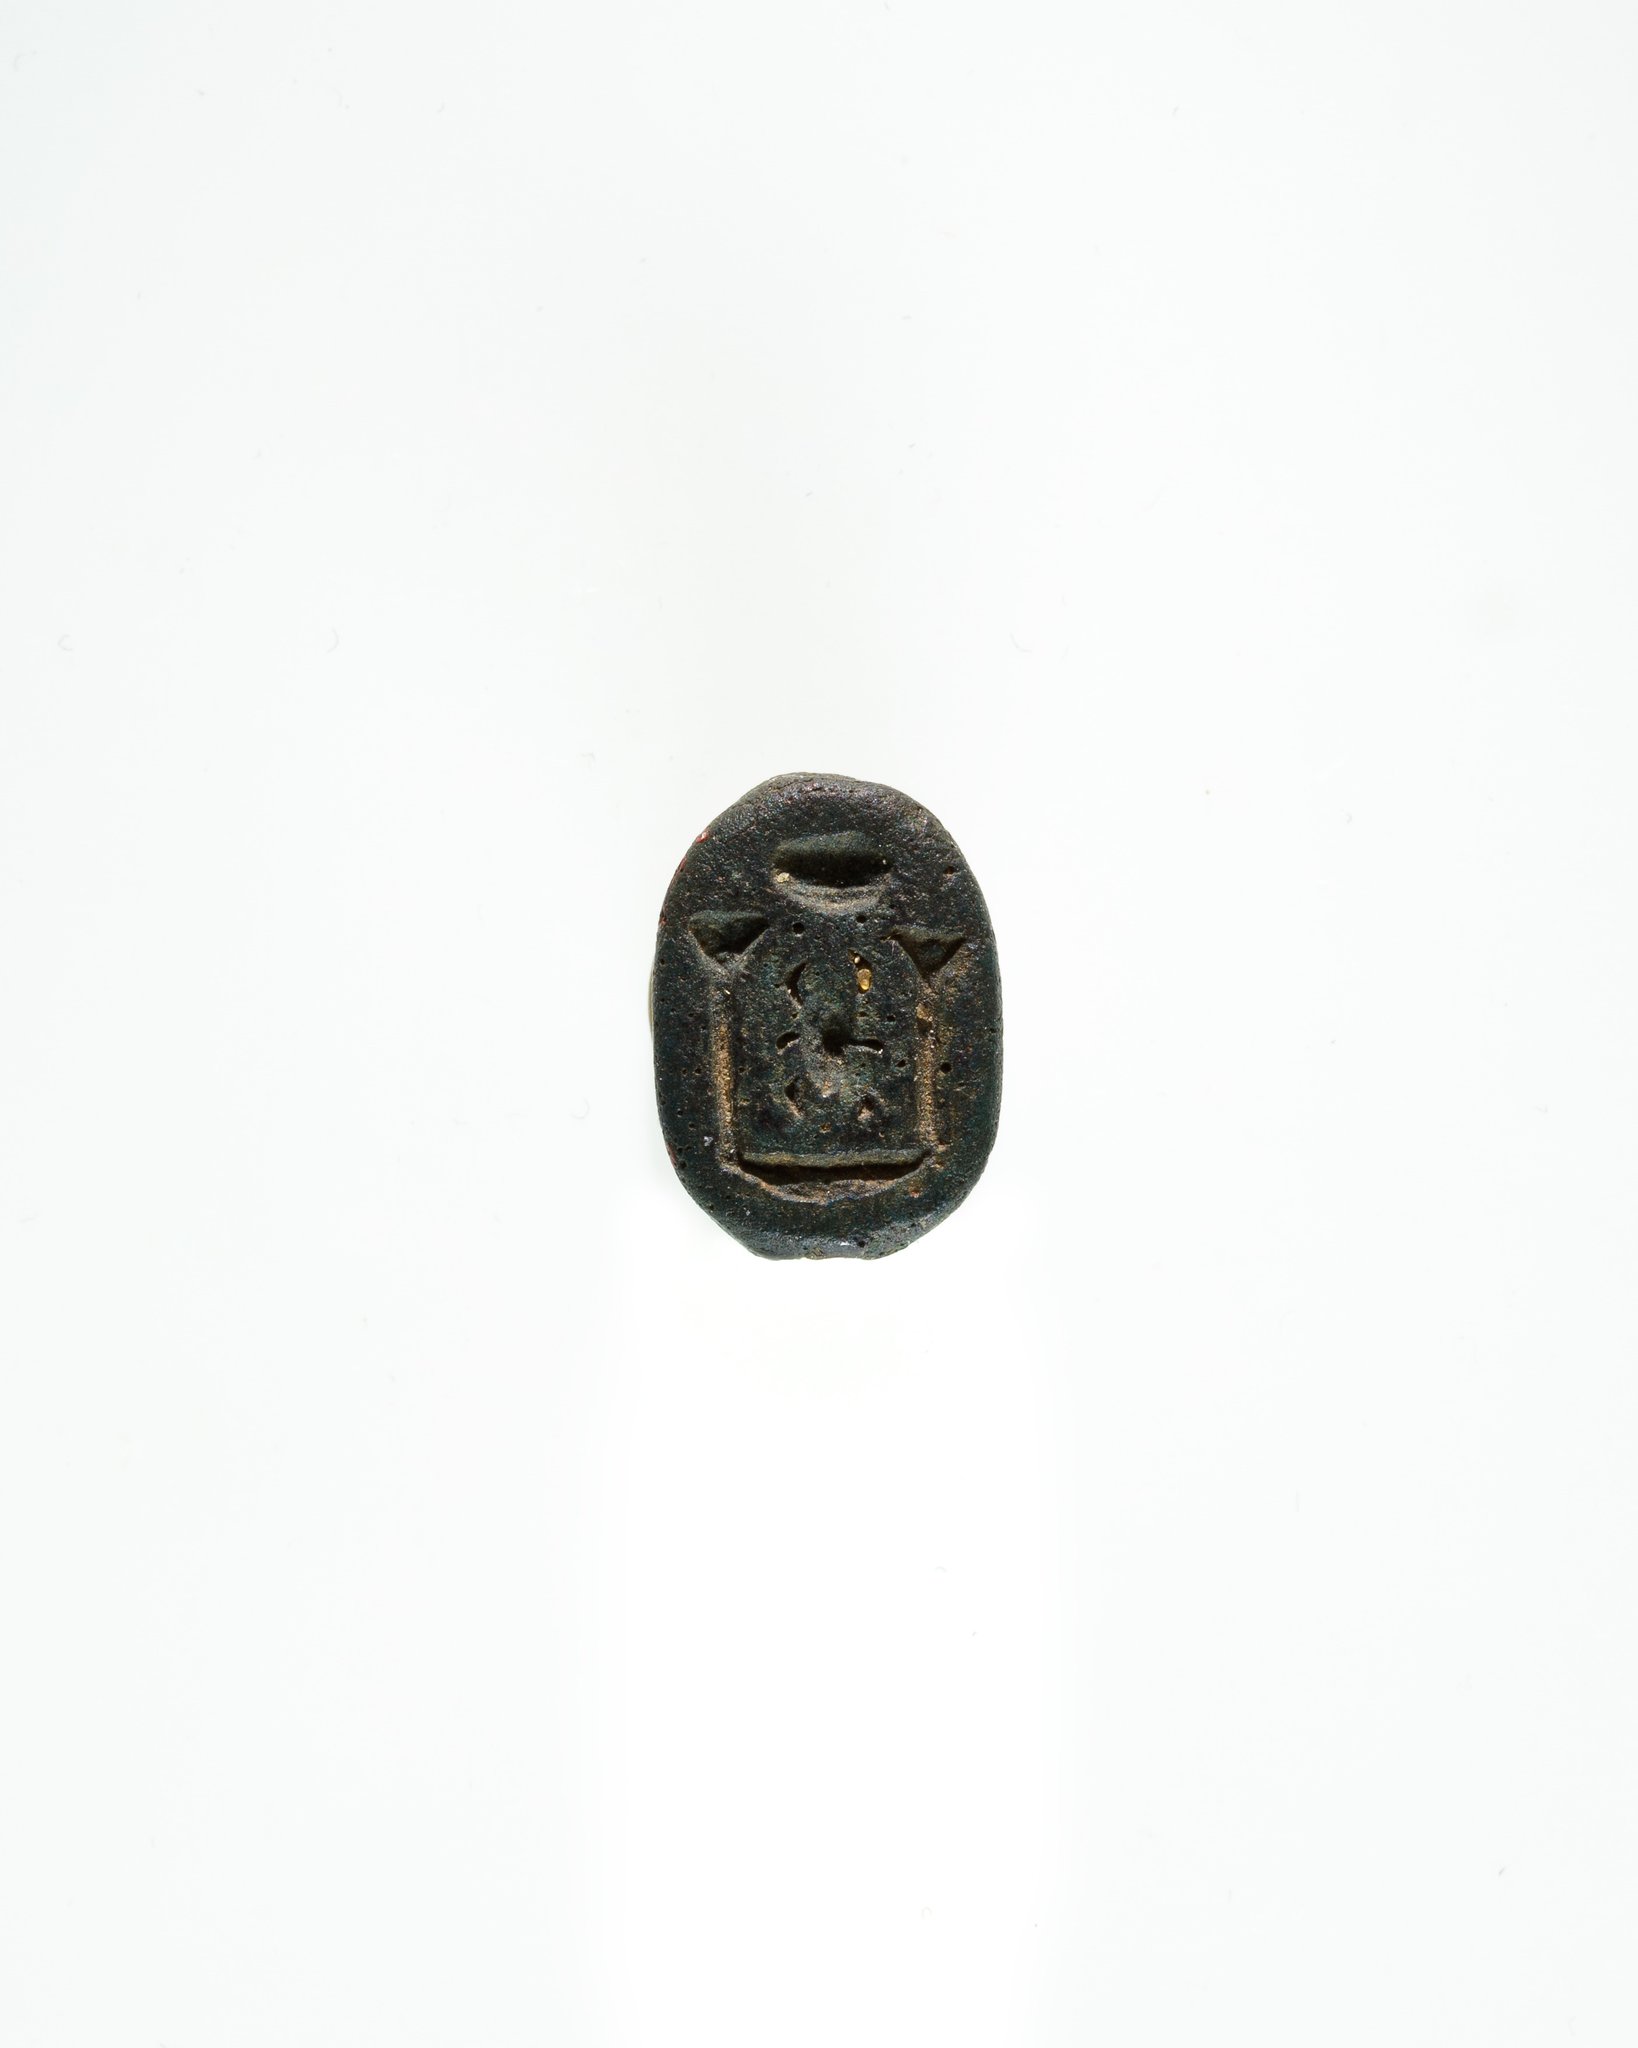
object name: scarab, beetle, papyrus, sun disk, neb, hieroglyph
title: Scarab with Papyrus and Beetle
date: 1550-1295 BCE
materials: faience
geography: egypt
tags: hieroglyphs,scarabs